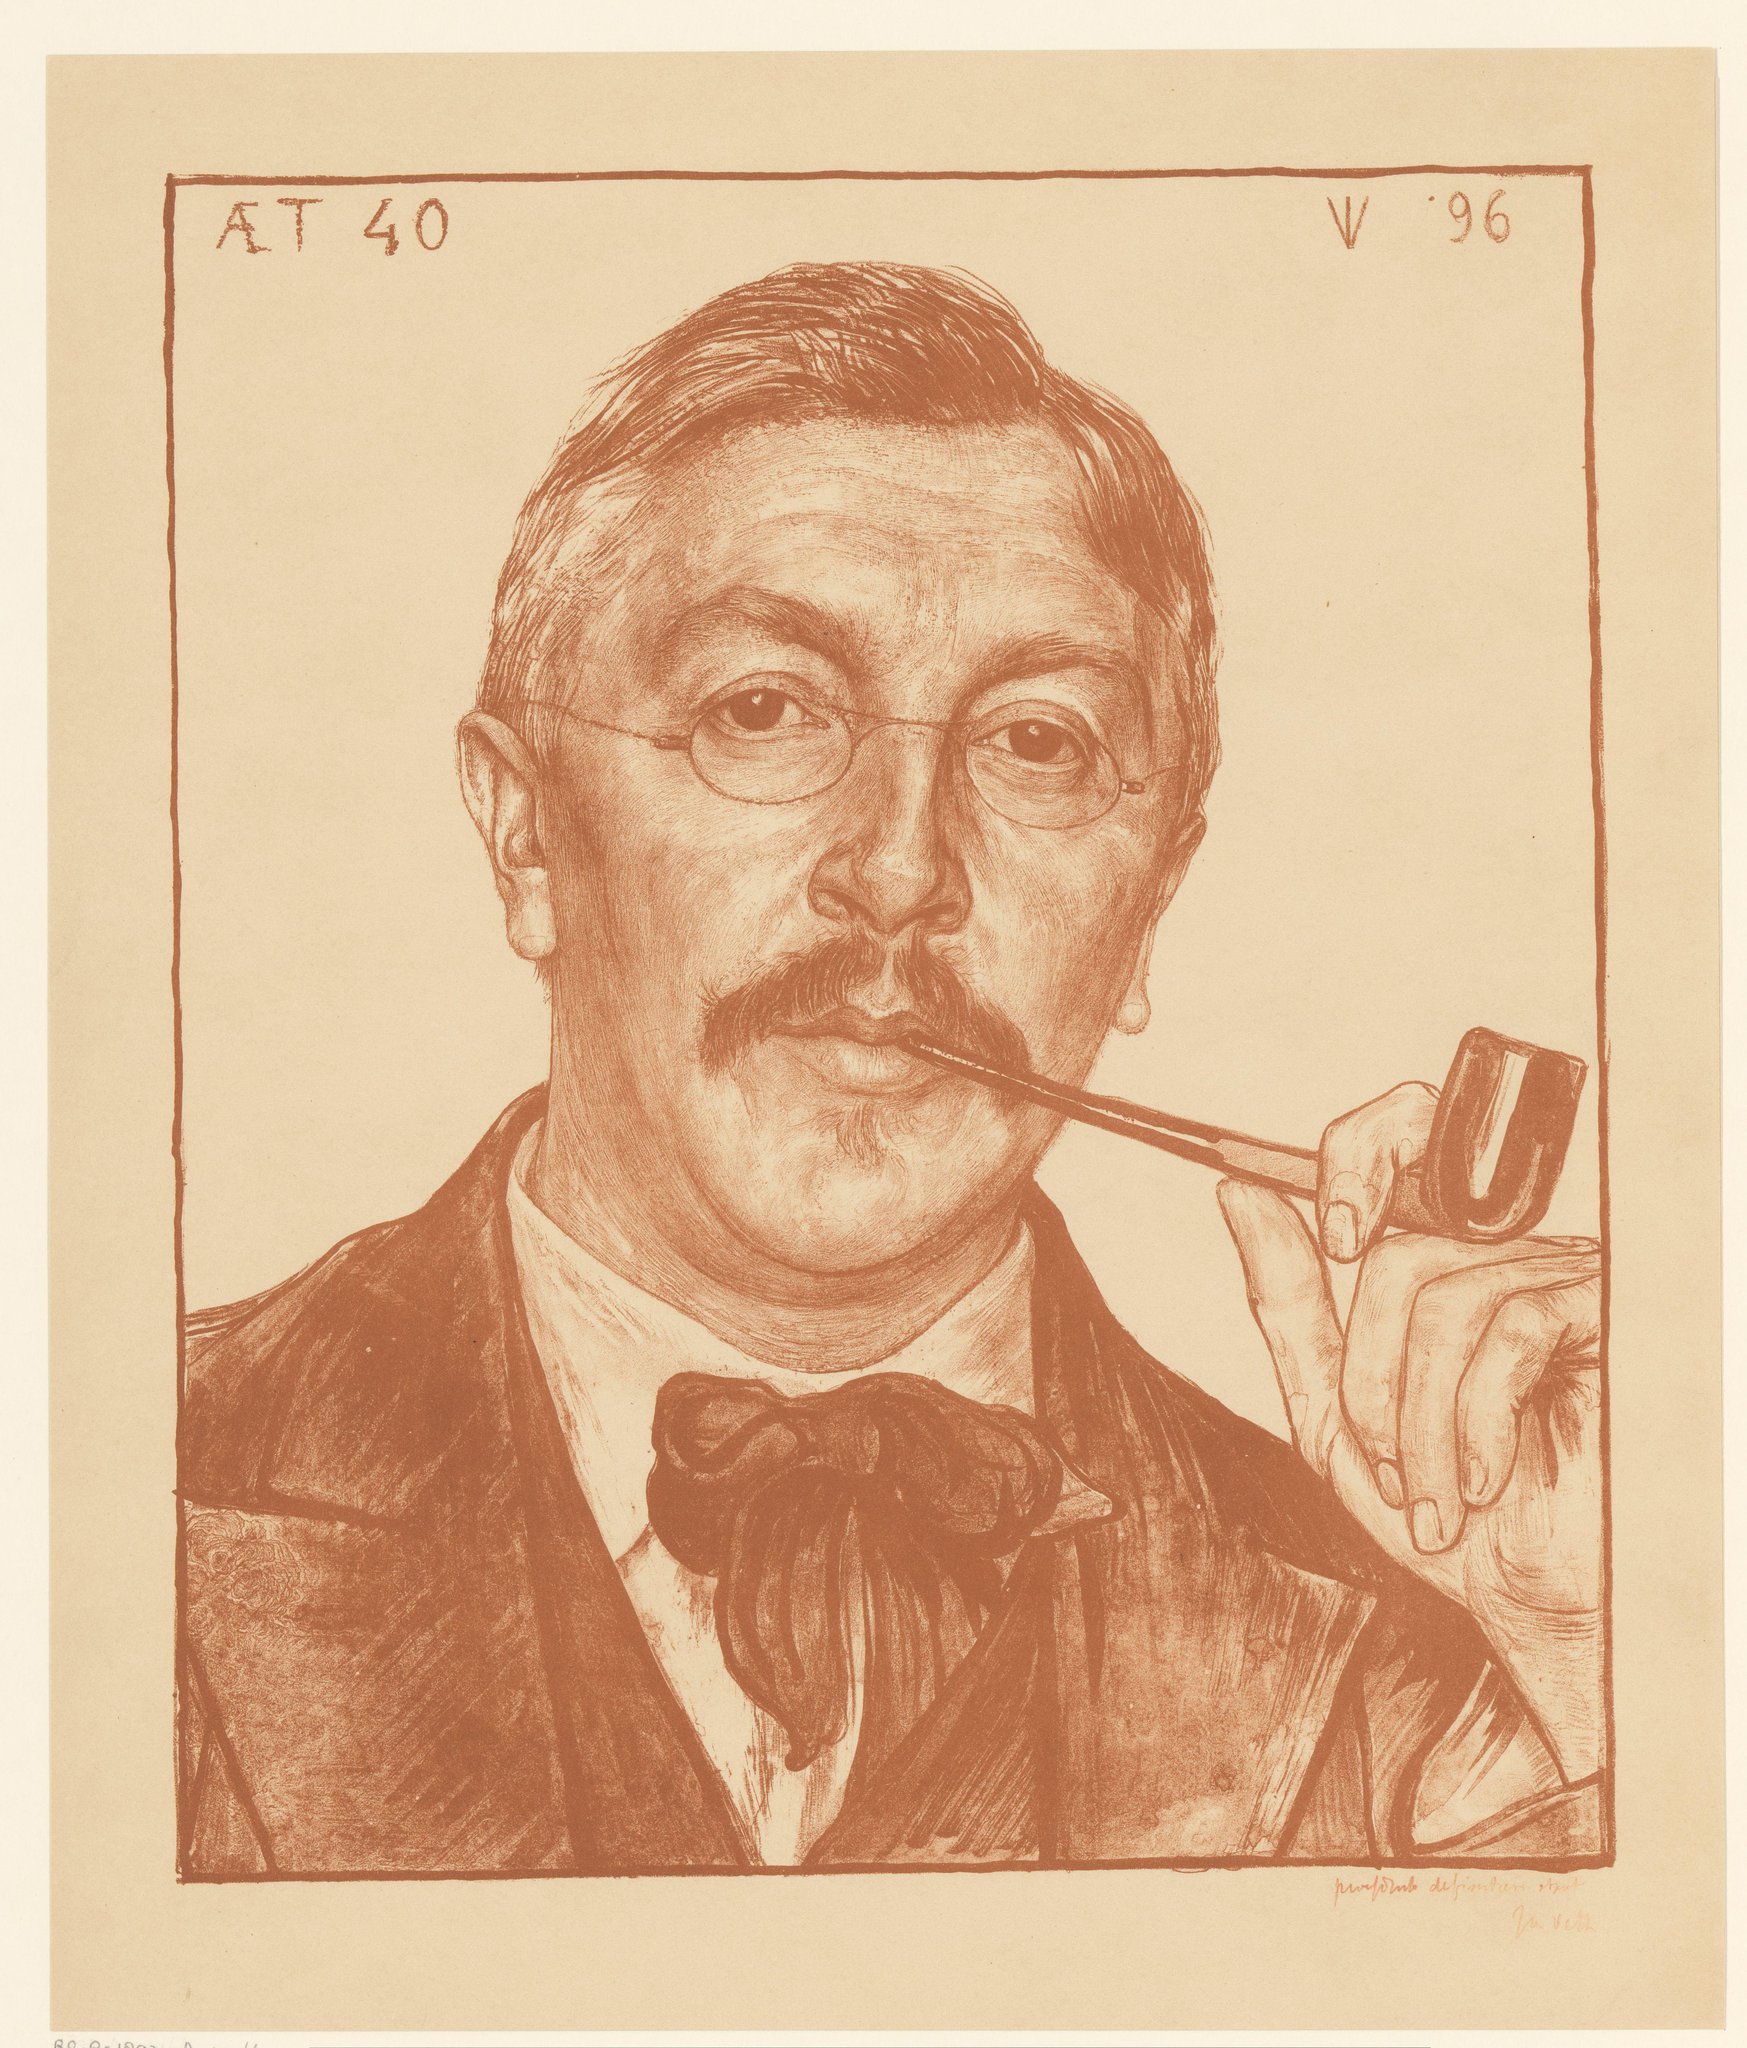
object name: print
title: Portretten van De Kroniek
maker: jan veth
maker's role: designer, draughtsman, painter, print maker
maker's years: 1864-1925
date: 1896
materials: paper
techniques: lithograph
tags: haarlem, painter, print maker, draughtsman, jac van looij, pipe ~ tobacco, historical persons (+ (full) bust portrait)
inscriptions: collector's mark: Lugt 2228, inscription: ‘proefdruk definitieve staat / Jan Veth’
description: Deze prent werd uitgegeven bij De Kroniek op 21 juni 1896.